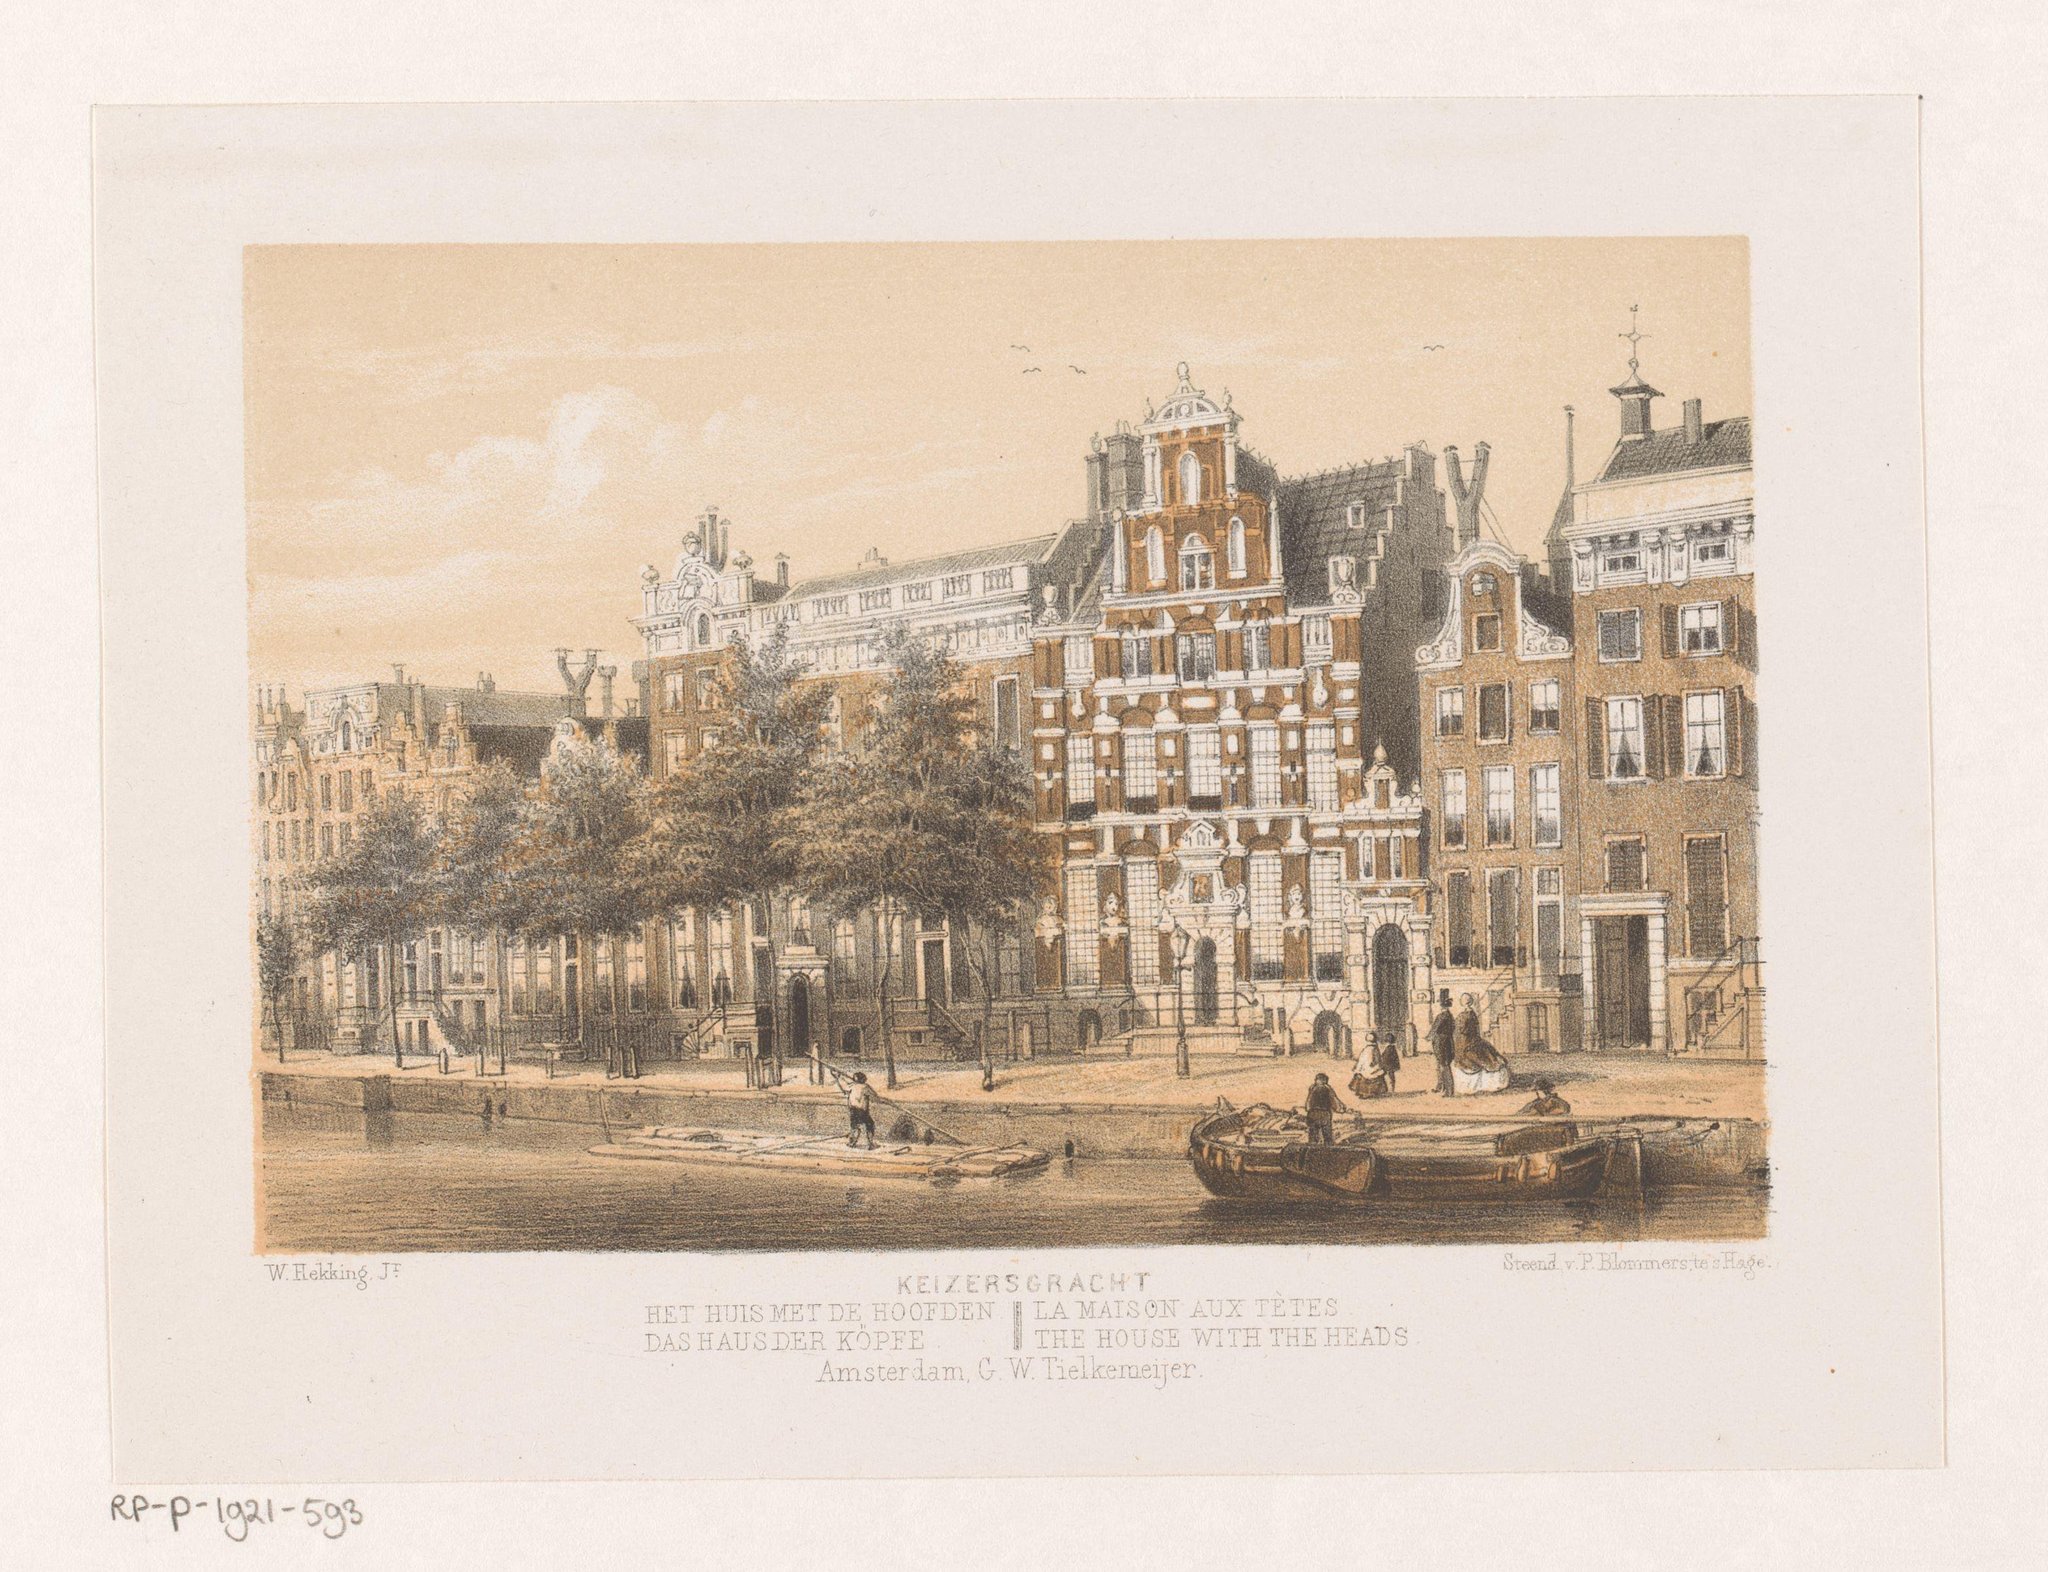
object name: print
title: Huis met de Hoofden aan de Keizersgracht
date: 1843-1887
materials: paper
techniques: tone lithography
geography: amsterdam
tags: canals, waters (in city)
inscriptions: collector's mark: Lugt 2233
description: Op de gracht lopen figuren, op het water liggen een vlot en een boot.